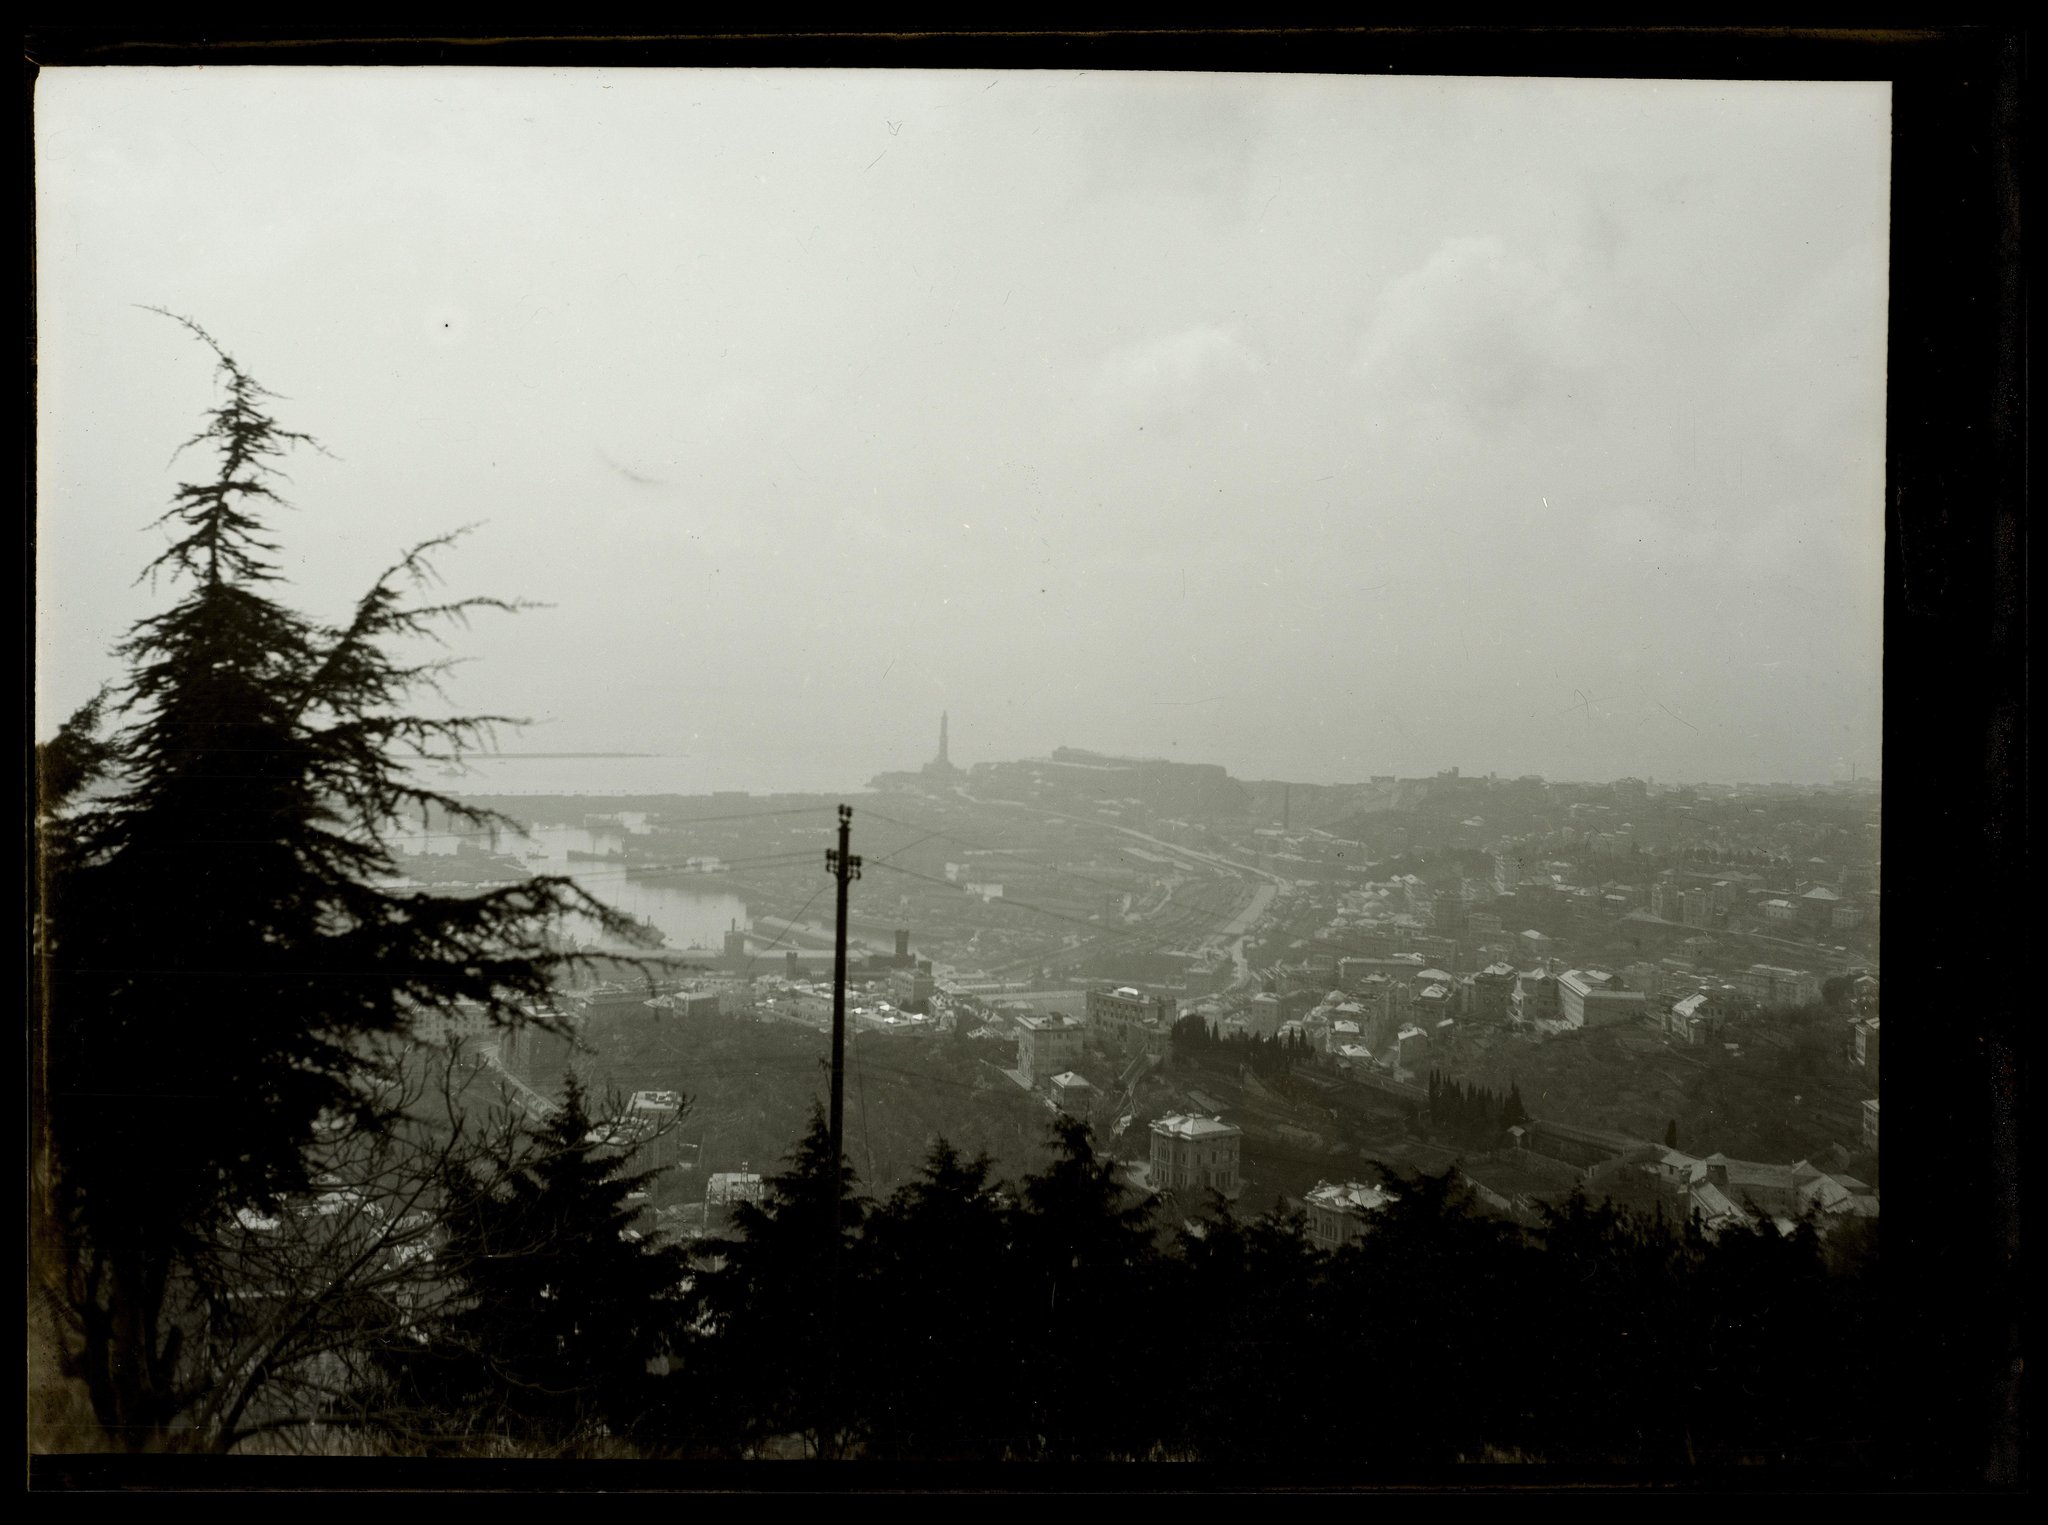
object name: photograph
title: Filmnegatief met opname van Genua, Pisa, Ravenna of Milaan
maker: Anonymous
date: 1907-1935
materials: film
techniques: gelatin silver negative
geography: italy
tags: italy